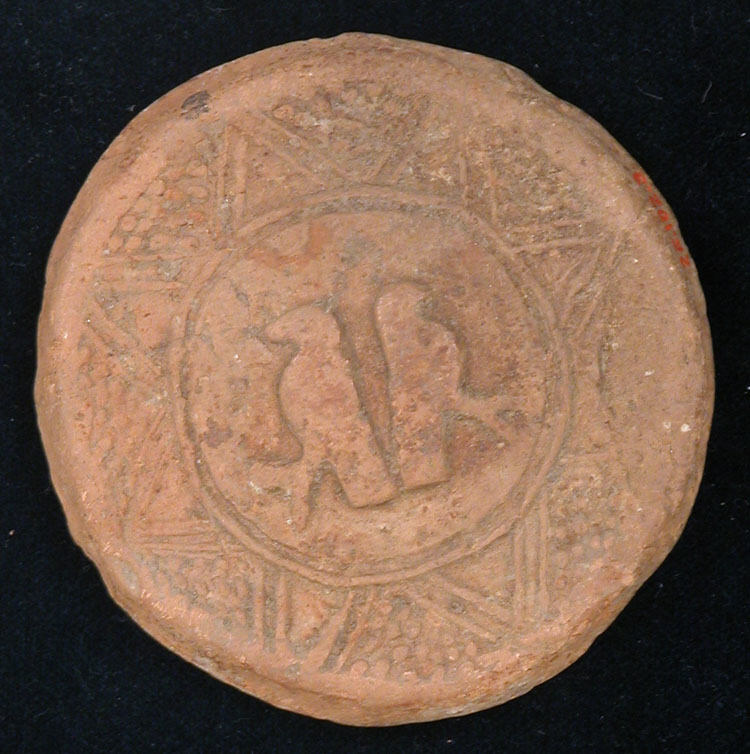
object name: bath scraper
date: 1101-1300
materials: earthenware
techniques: molding, relief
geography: iran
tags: birds